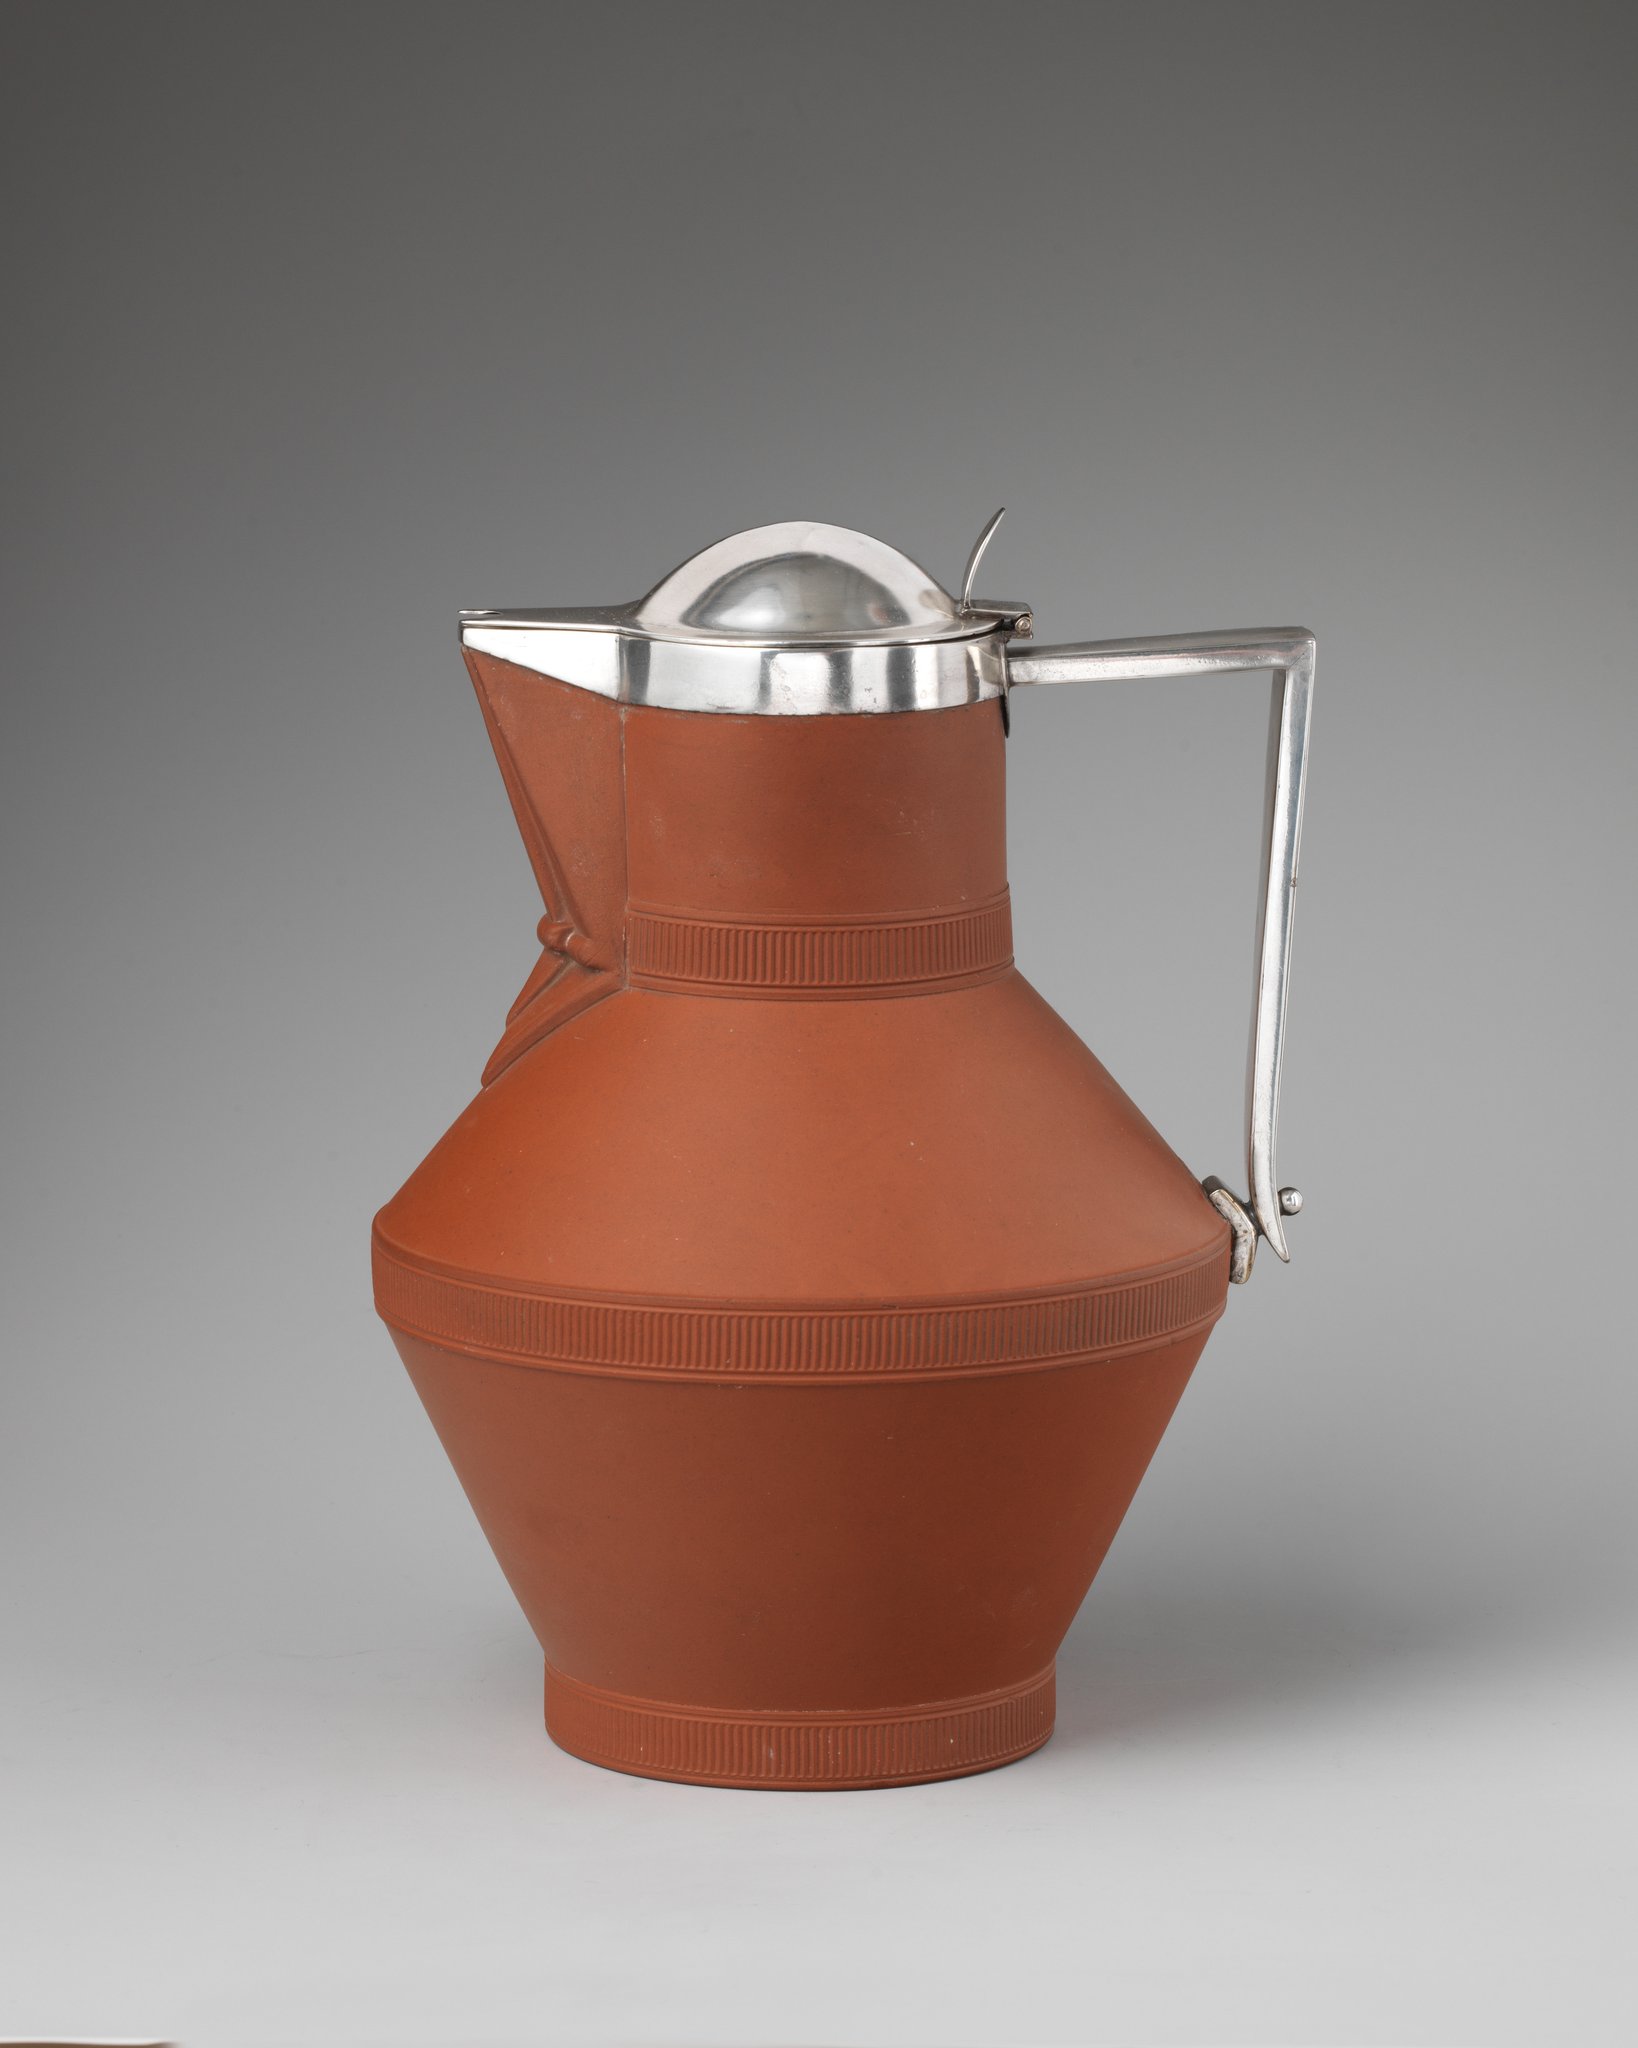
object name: jug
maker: christopher dresser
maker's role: designer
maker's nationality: british, scottish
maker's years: 1834-1904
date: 1872-1875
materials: earthenware, silver